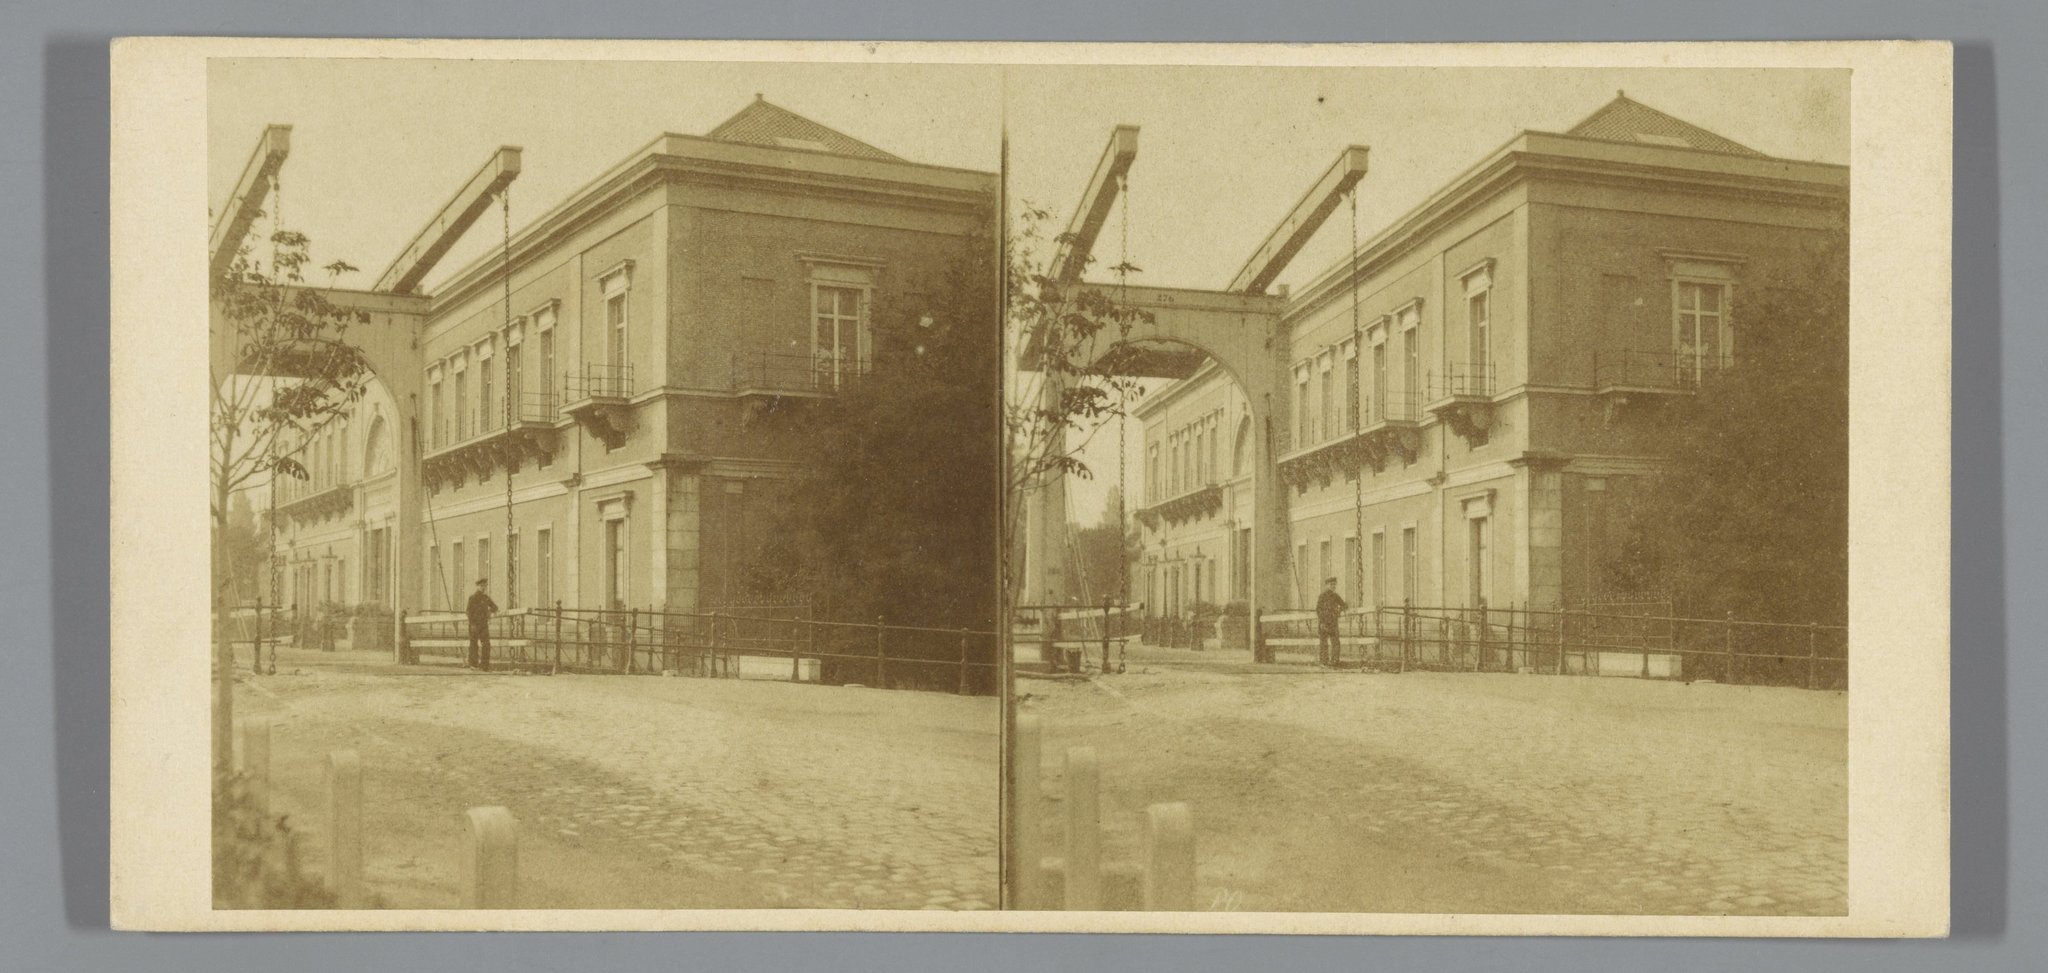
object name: stereograph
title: Gebouw van Artis met de brug over de Nieuwe Prinsengracht, Amsterdam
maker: pieter oosterhuis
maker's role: draughtsman, print maker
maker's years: 1816-1885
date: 1859-1864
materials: cardboard, paper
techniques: albumen print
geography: amsterdam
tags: bridge in city across river, canal, etc., street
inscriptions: number: ‘29’, inscription: ‘fo. Pieter Oosterhuis.’